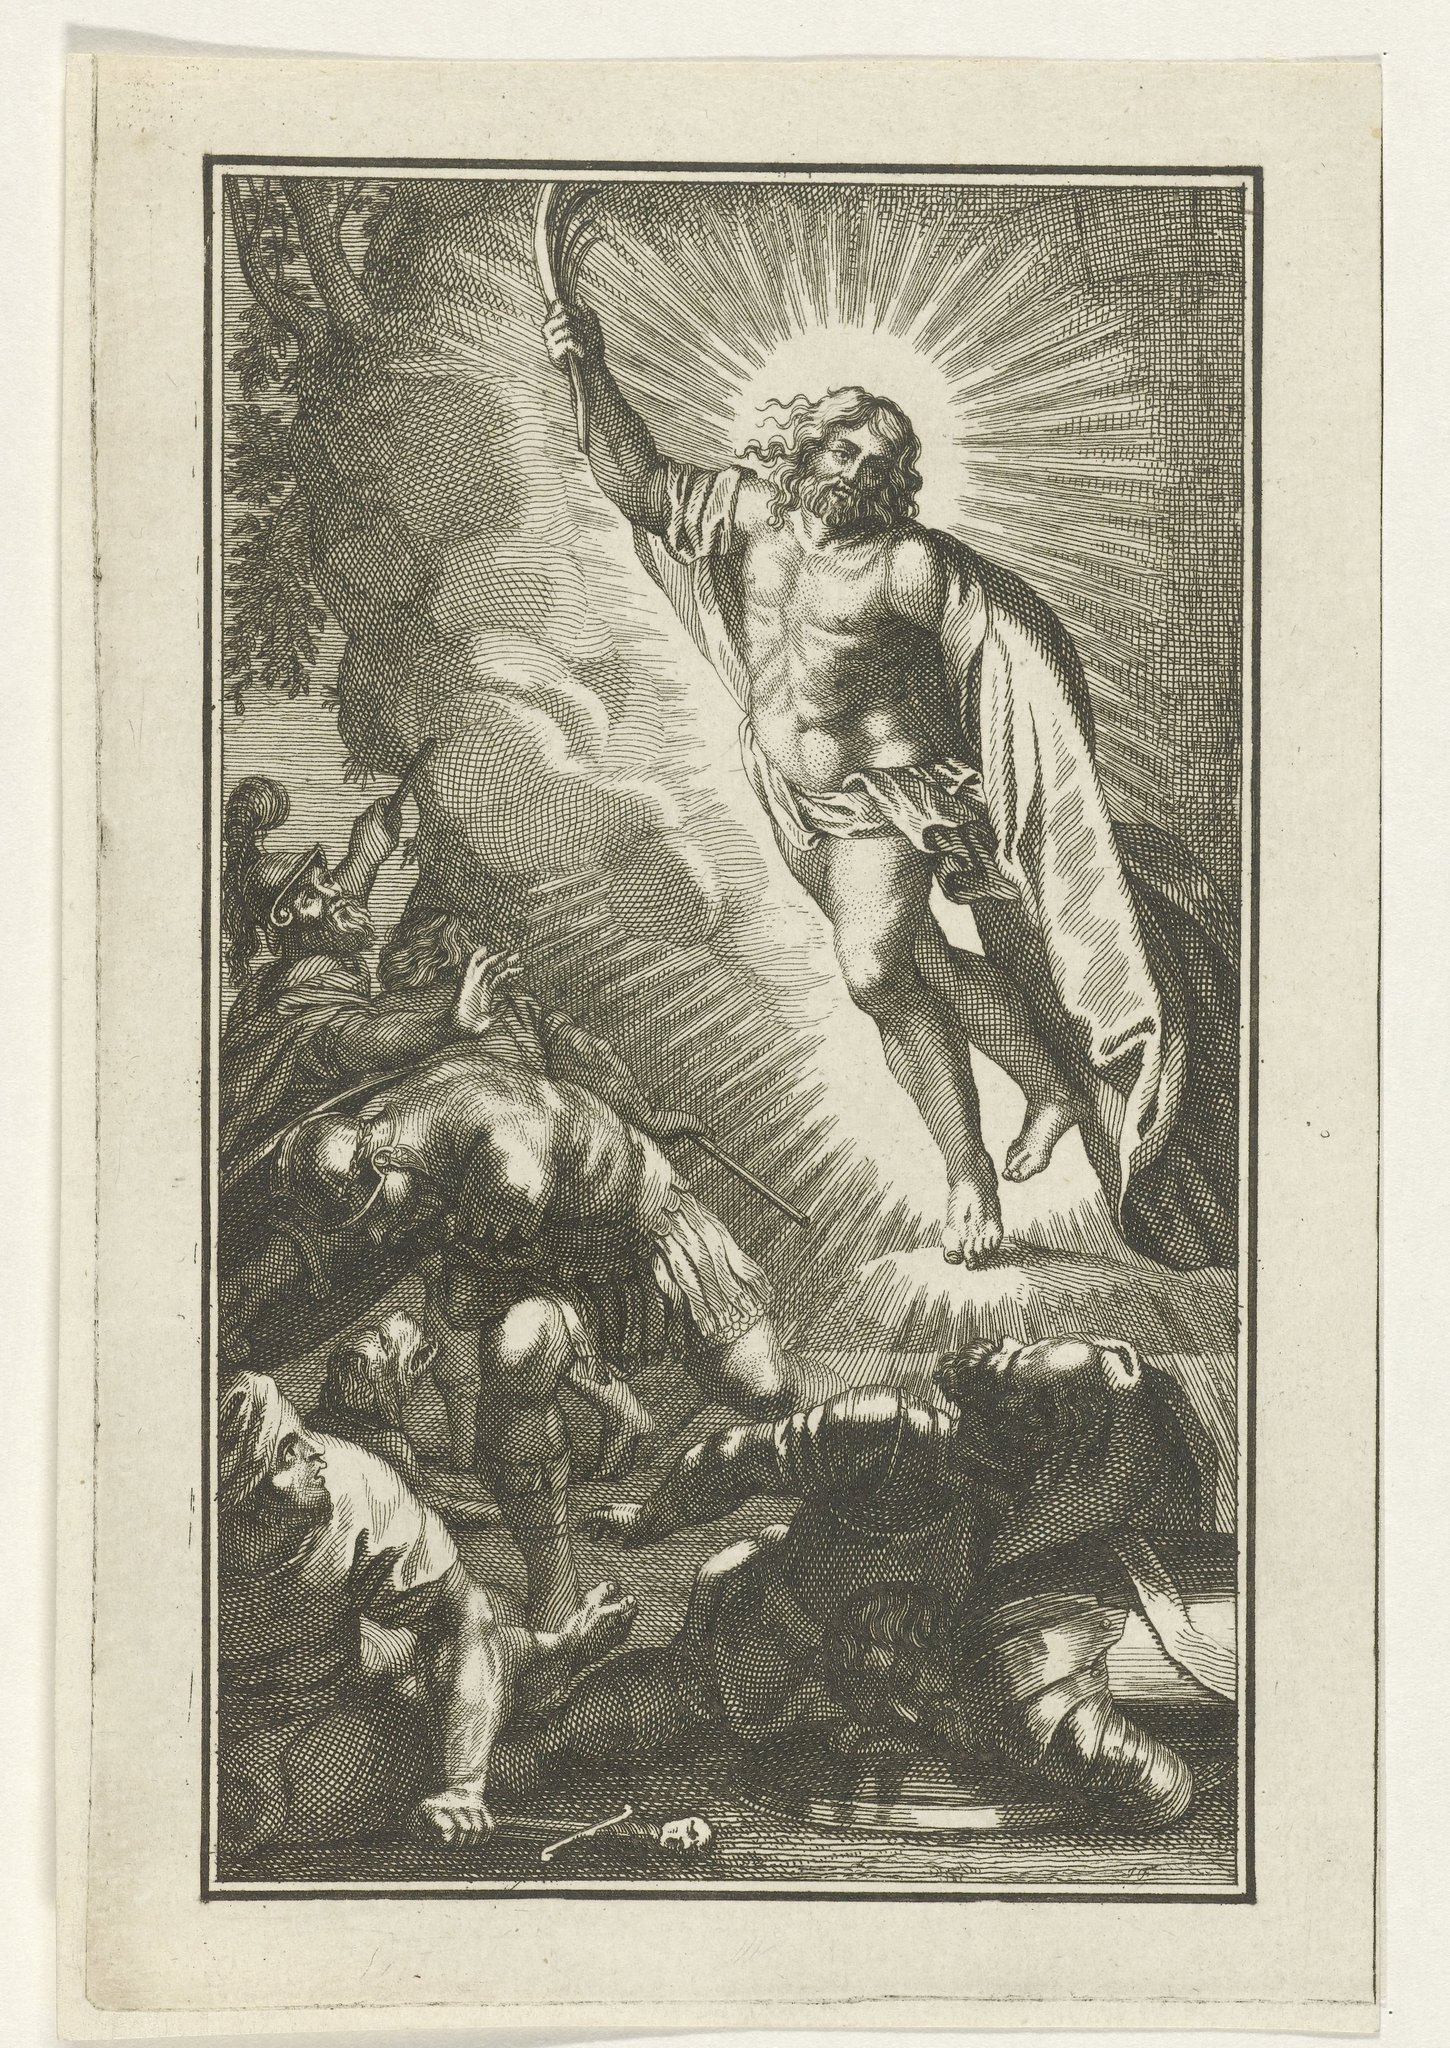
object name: print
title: Verrijzenis van Christus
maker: jacob folkema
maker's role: draughtsman, print maker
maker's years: 1692-1767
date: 1702-1767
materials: paper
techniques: etching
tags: christ, usually holding a banner, arises from the grave; often combined with sleeping and/or frightened soldiers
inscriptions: collector's mark: Lugt 240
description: Christus is opgestaan uit zijn graf en staat met een palmtak in zijn hand op een steen. Een aantal uit hun slaap ontwaakte bewakers kijkt verschrikt omhoog, anderen beschermen hun ogen tegen de verblindende stralen die Christus omringen.